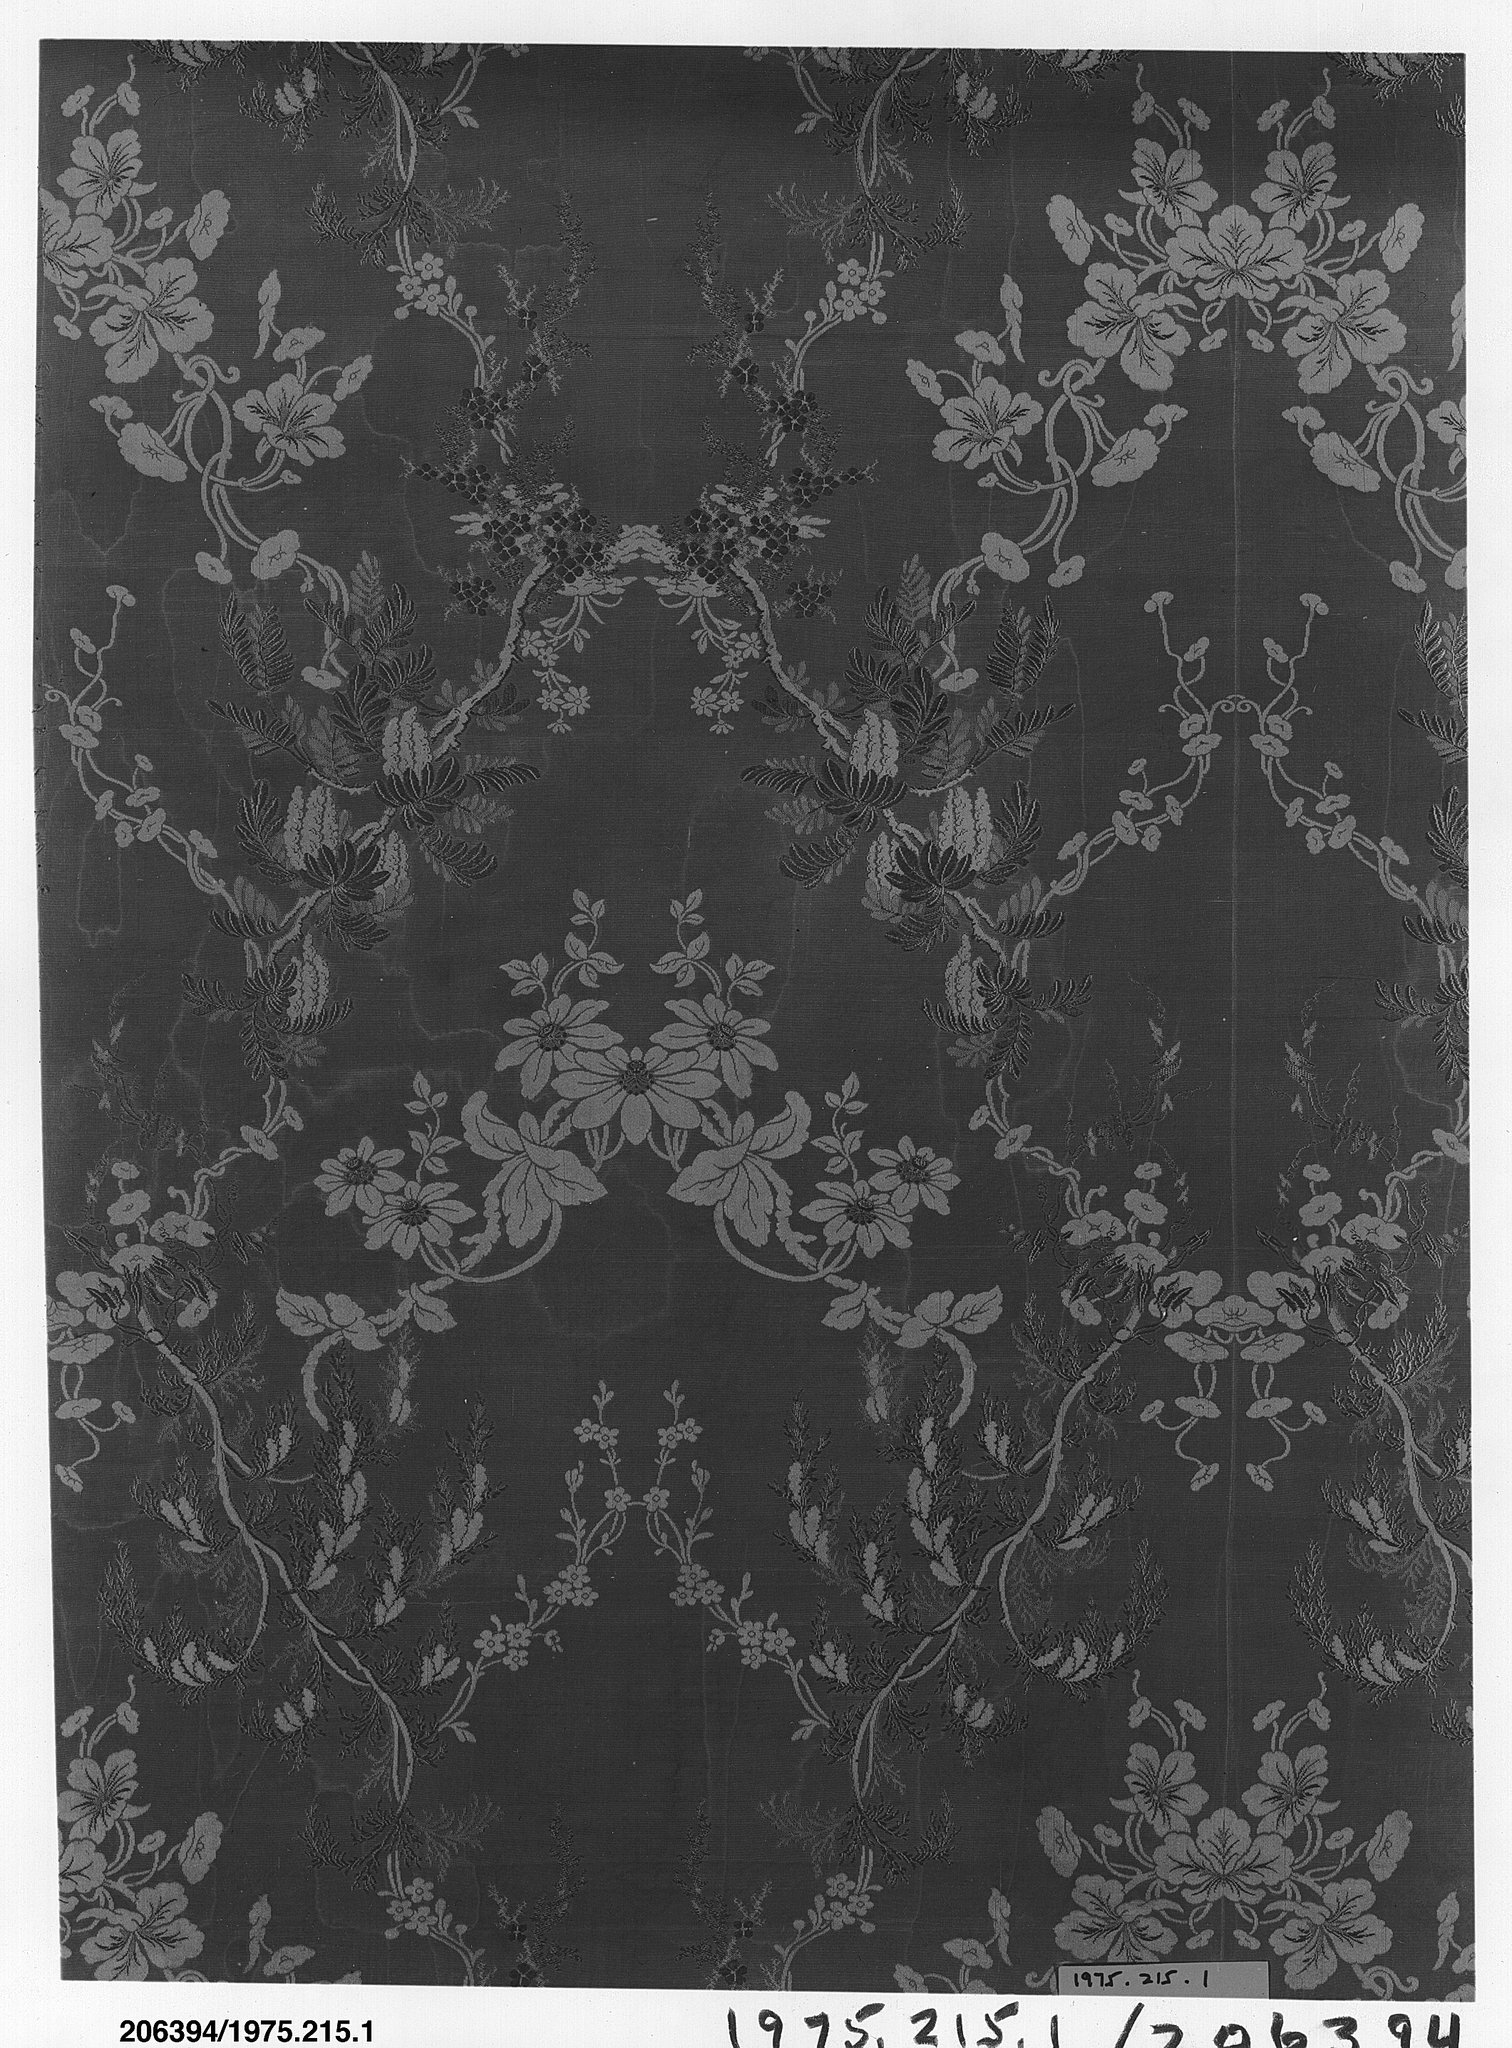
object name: length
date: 1850-1859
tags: flowers